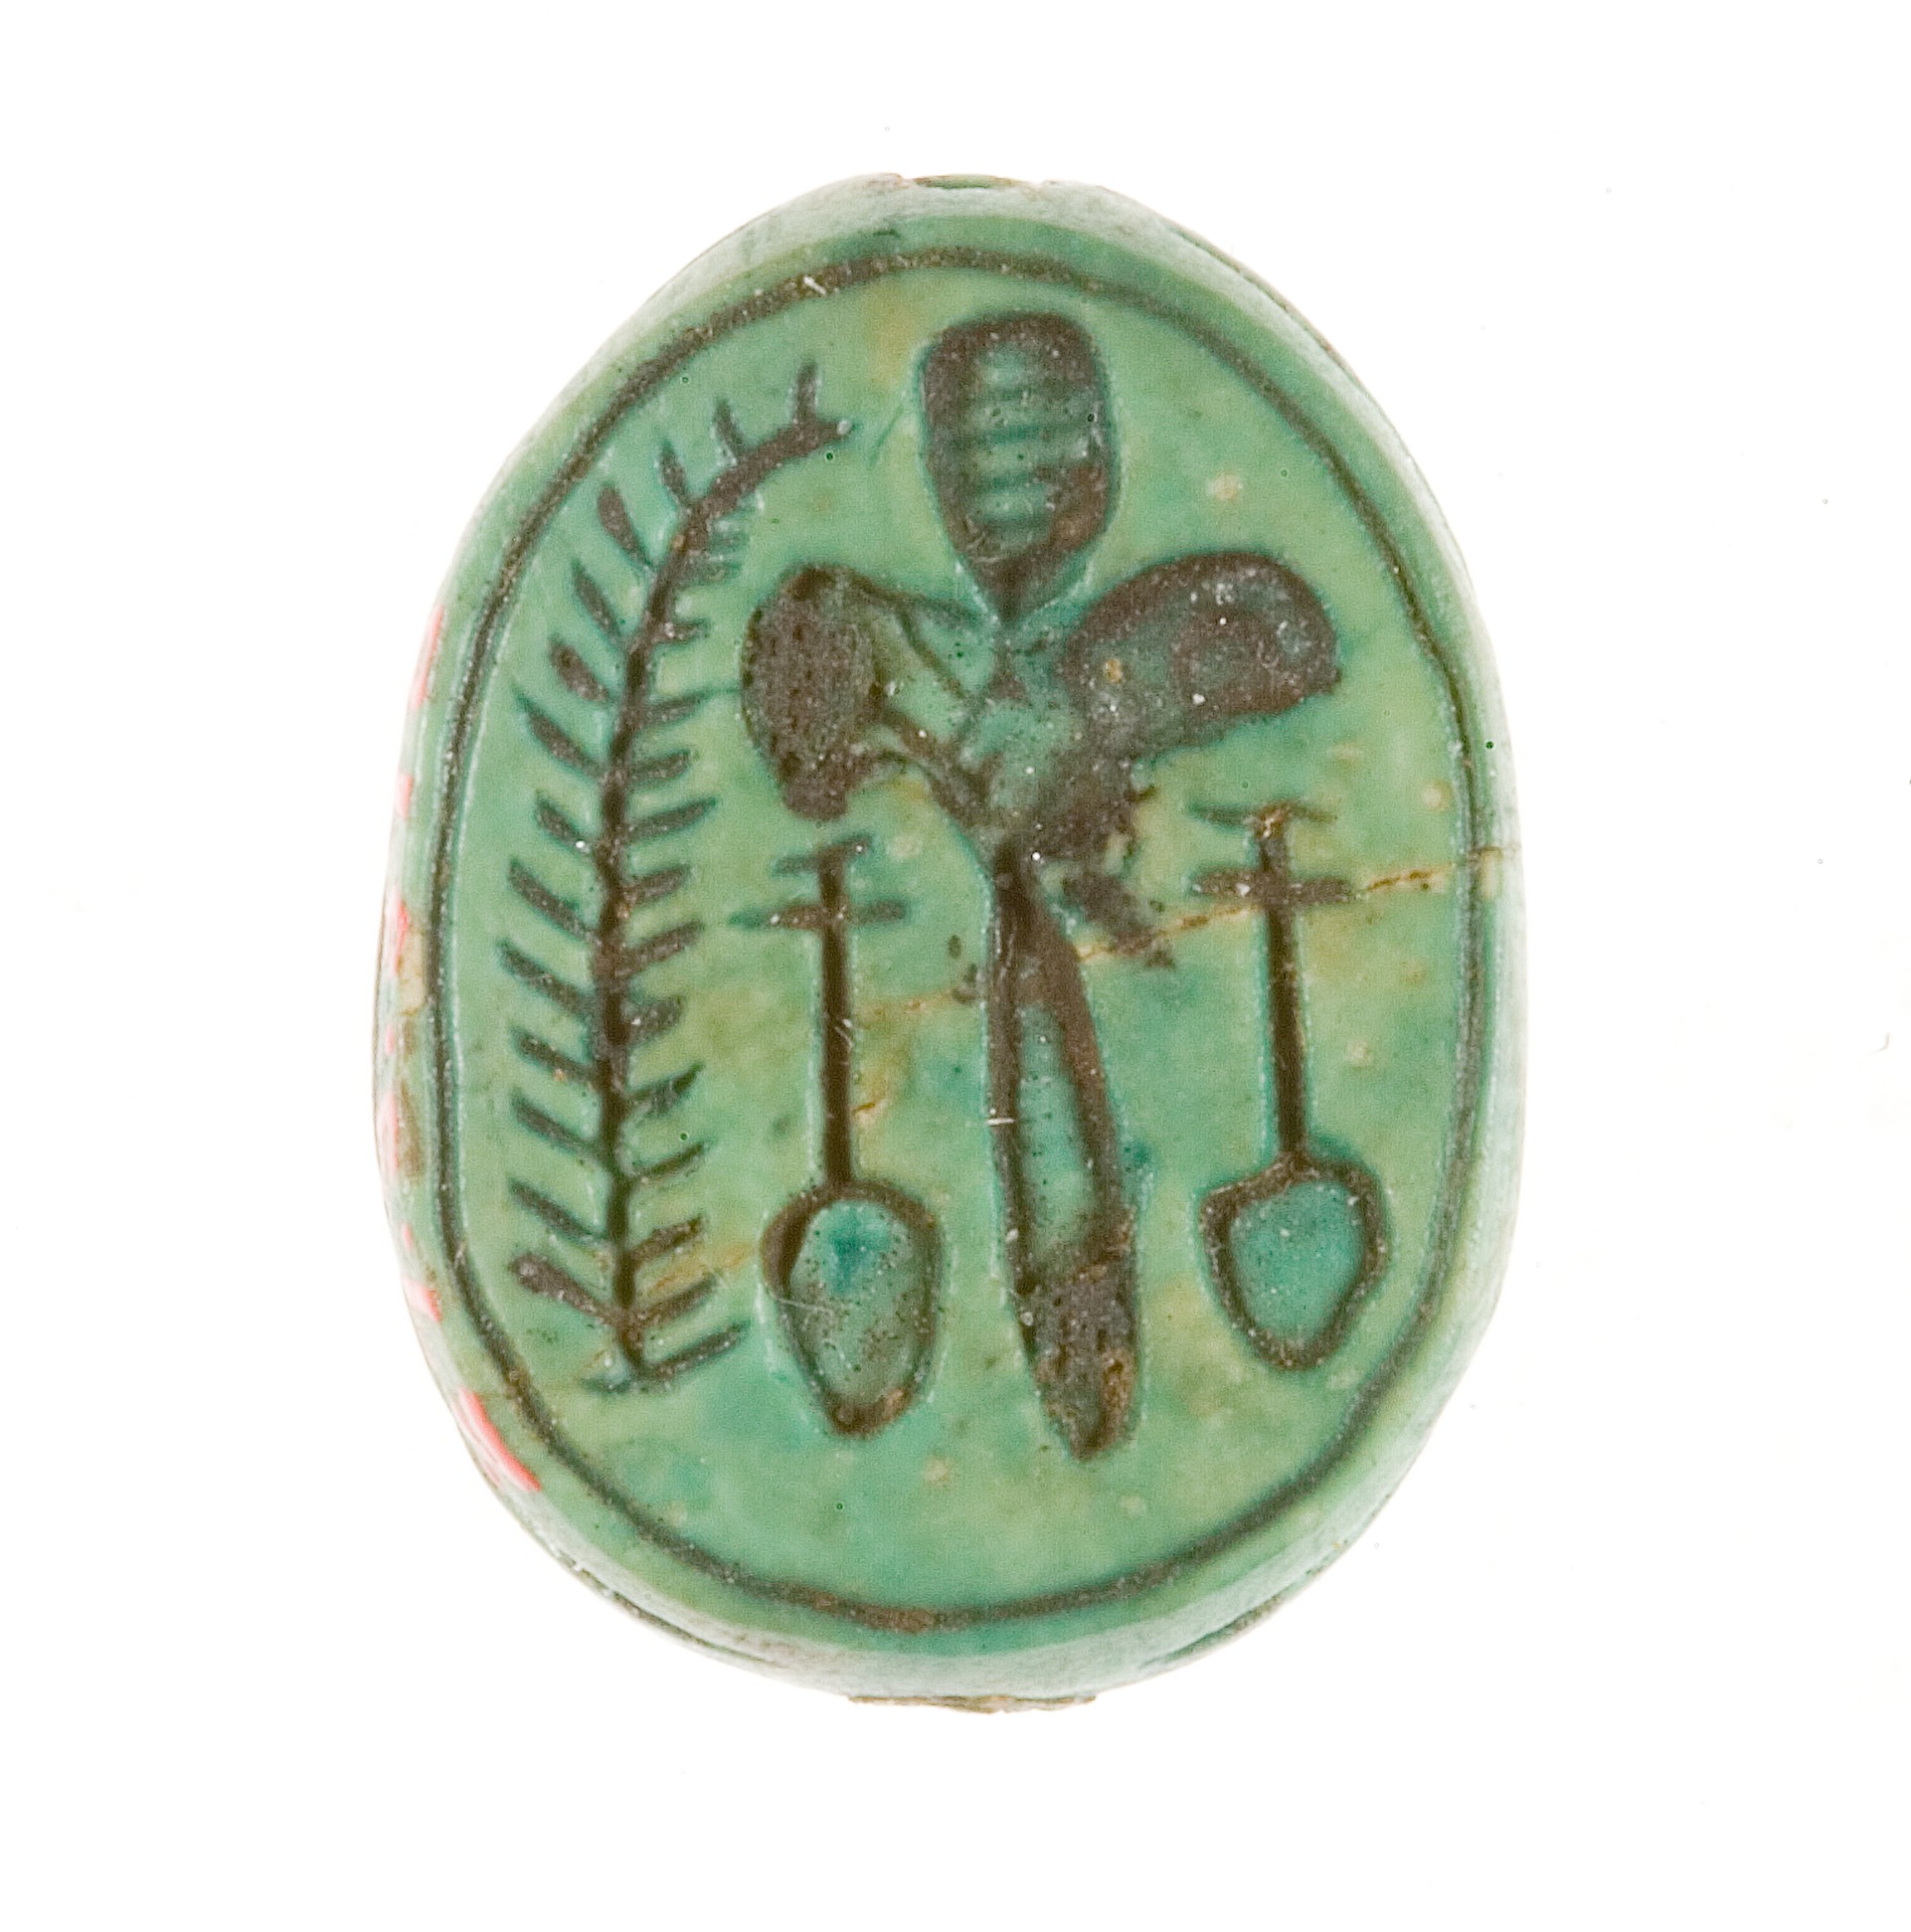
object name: scarab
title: Scarab Inscribed with a Hieroglyphic Motif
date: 1479-1458 BCE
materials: stone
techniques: glazing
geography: egypt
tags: hieroglyphs,scarabs